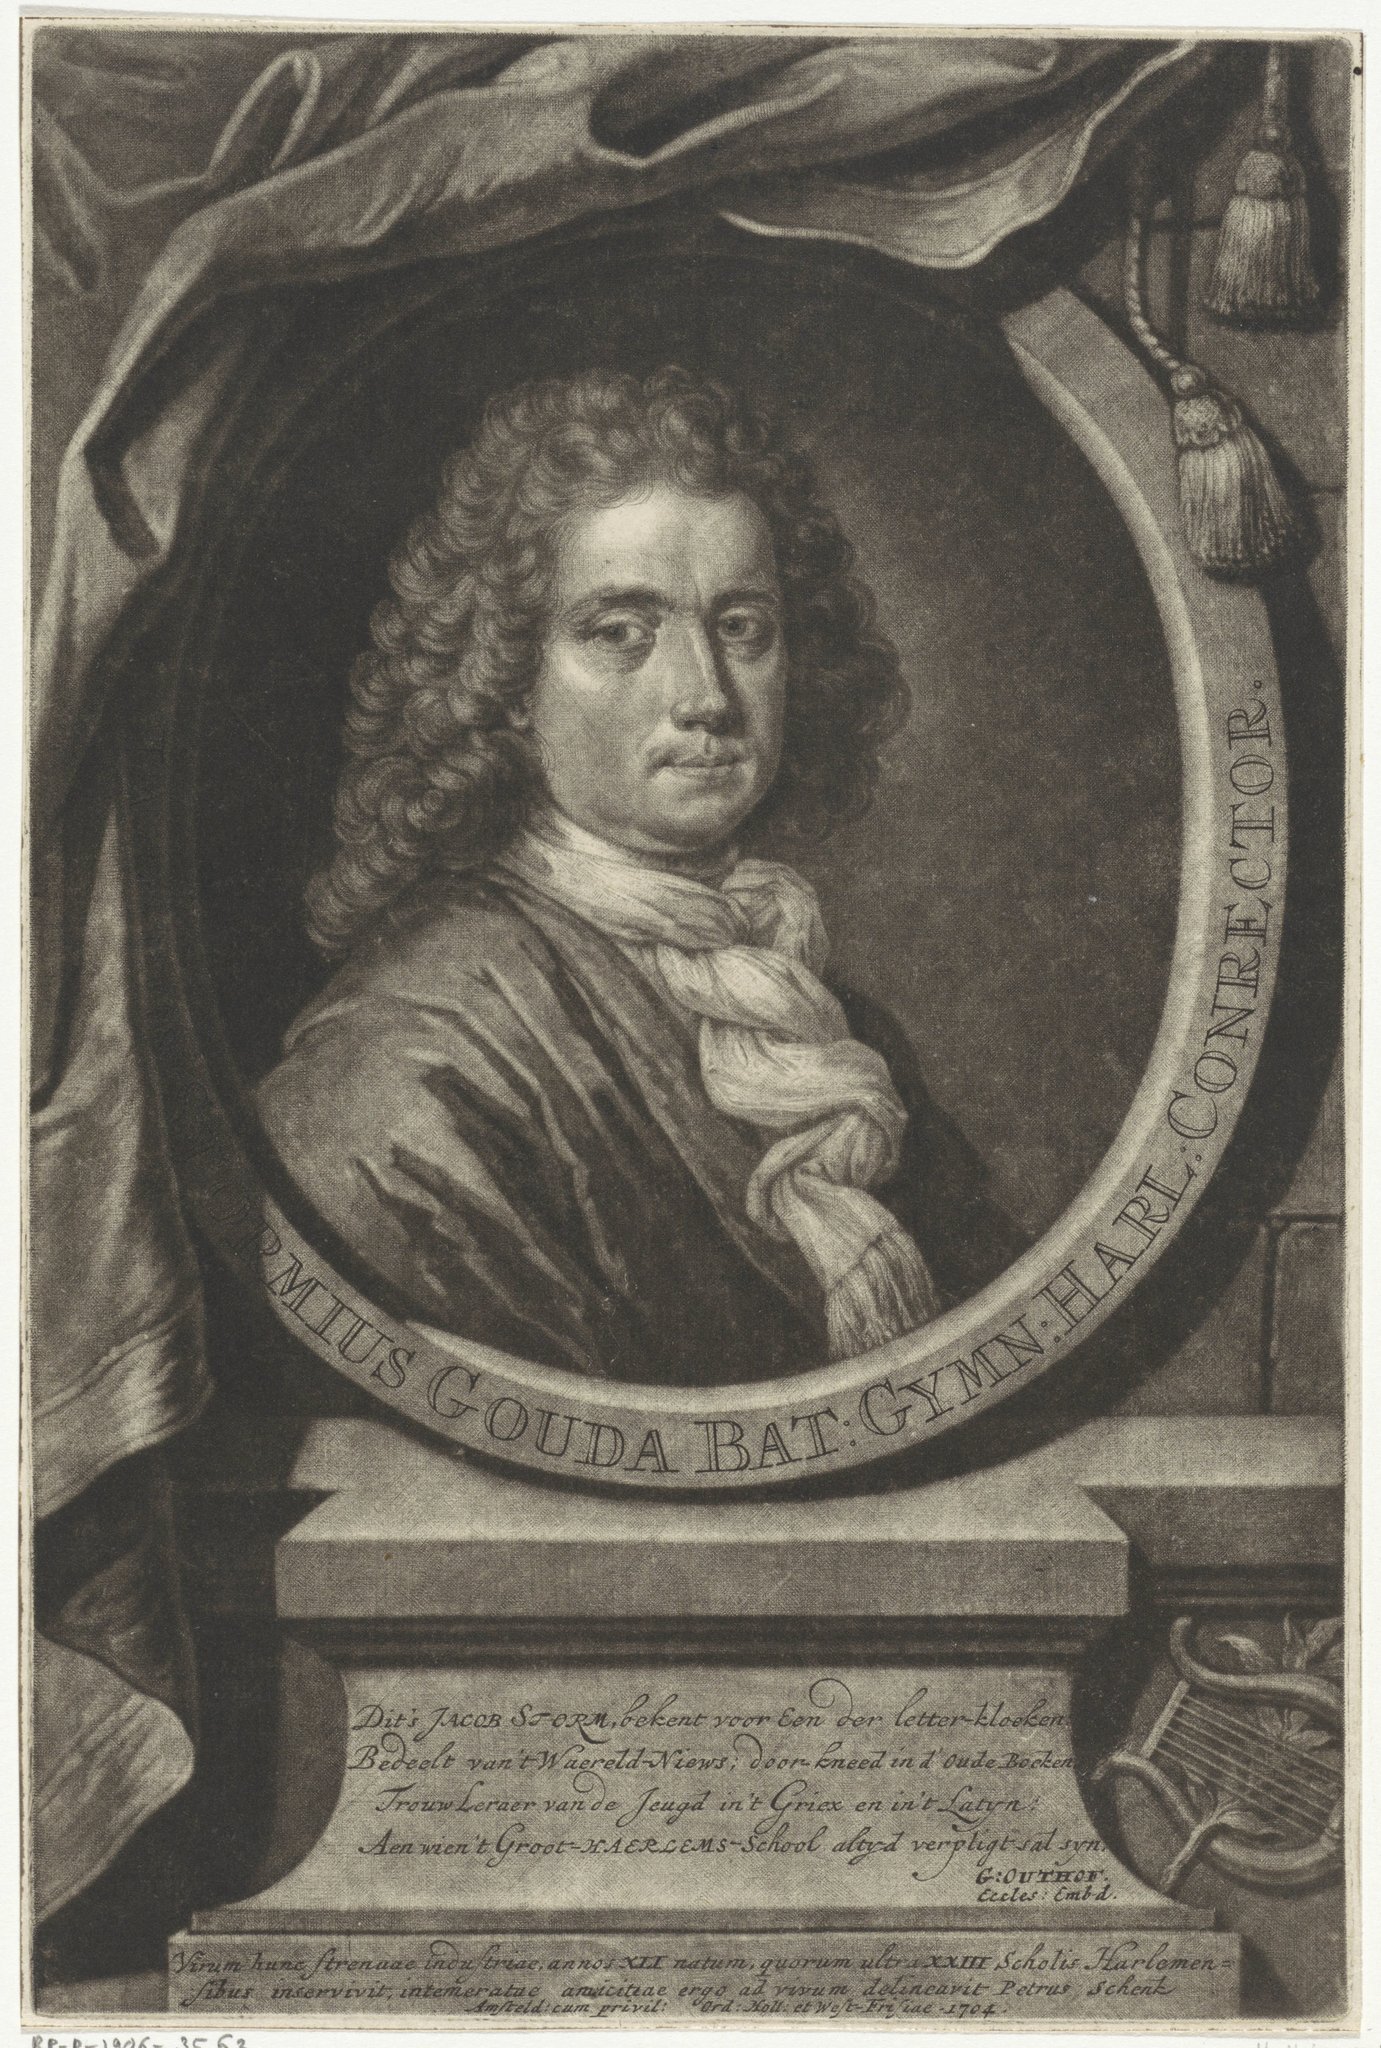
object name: print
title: Portret van Jacob Storm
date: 1704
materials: paper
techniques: engraving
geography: amsterdam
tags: jacob storm, lyre, cithara, psaltery, wig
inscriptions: collector's mark: Lugt 2228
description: Jacob Storm, docent aan het Gymnasium te Haarlem.